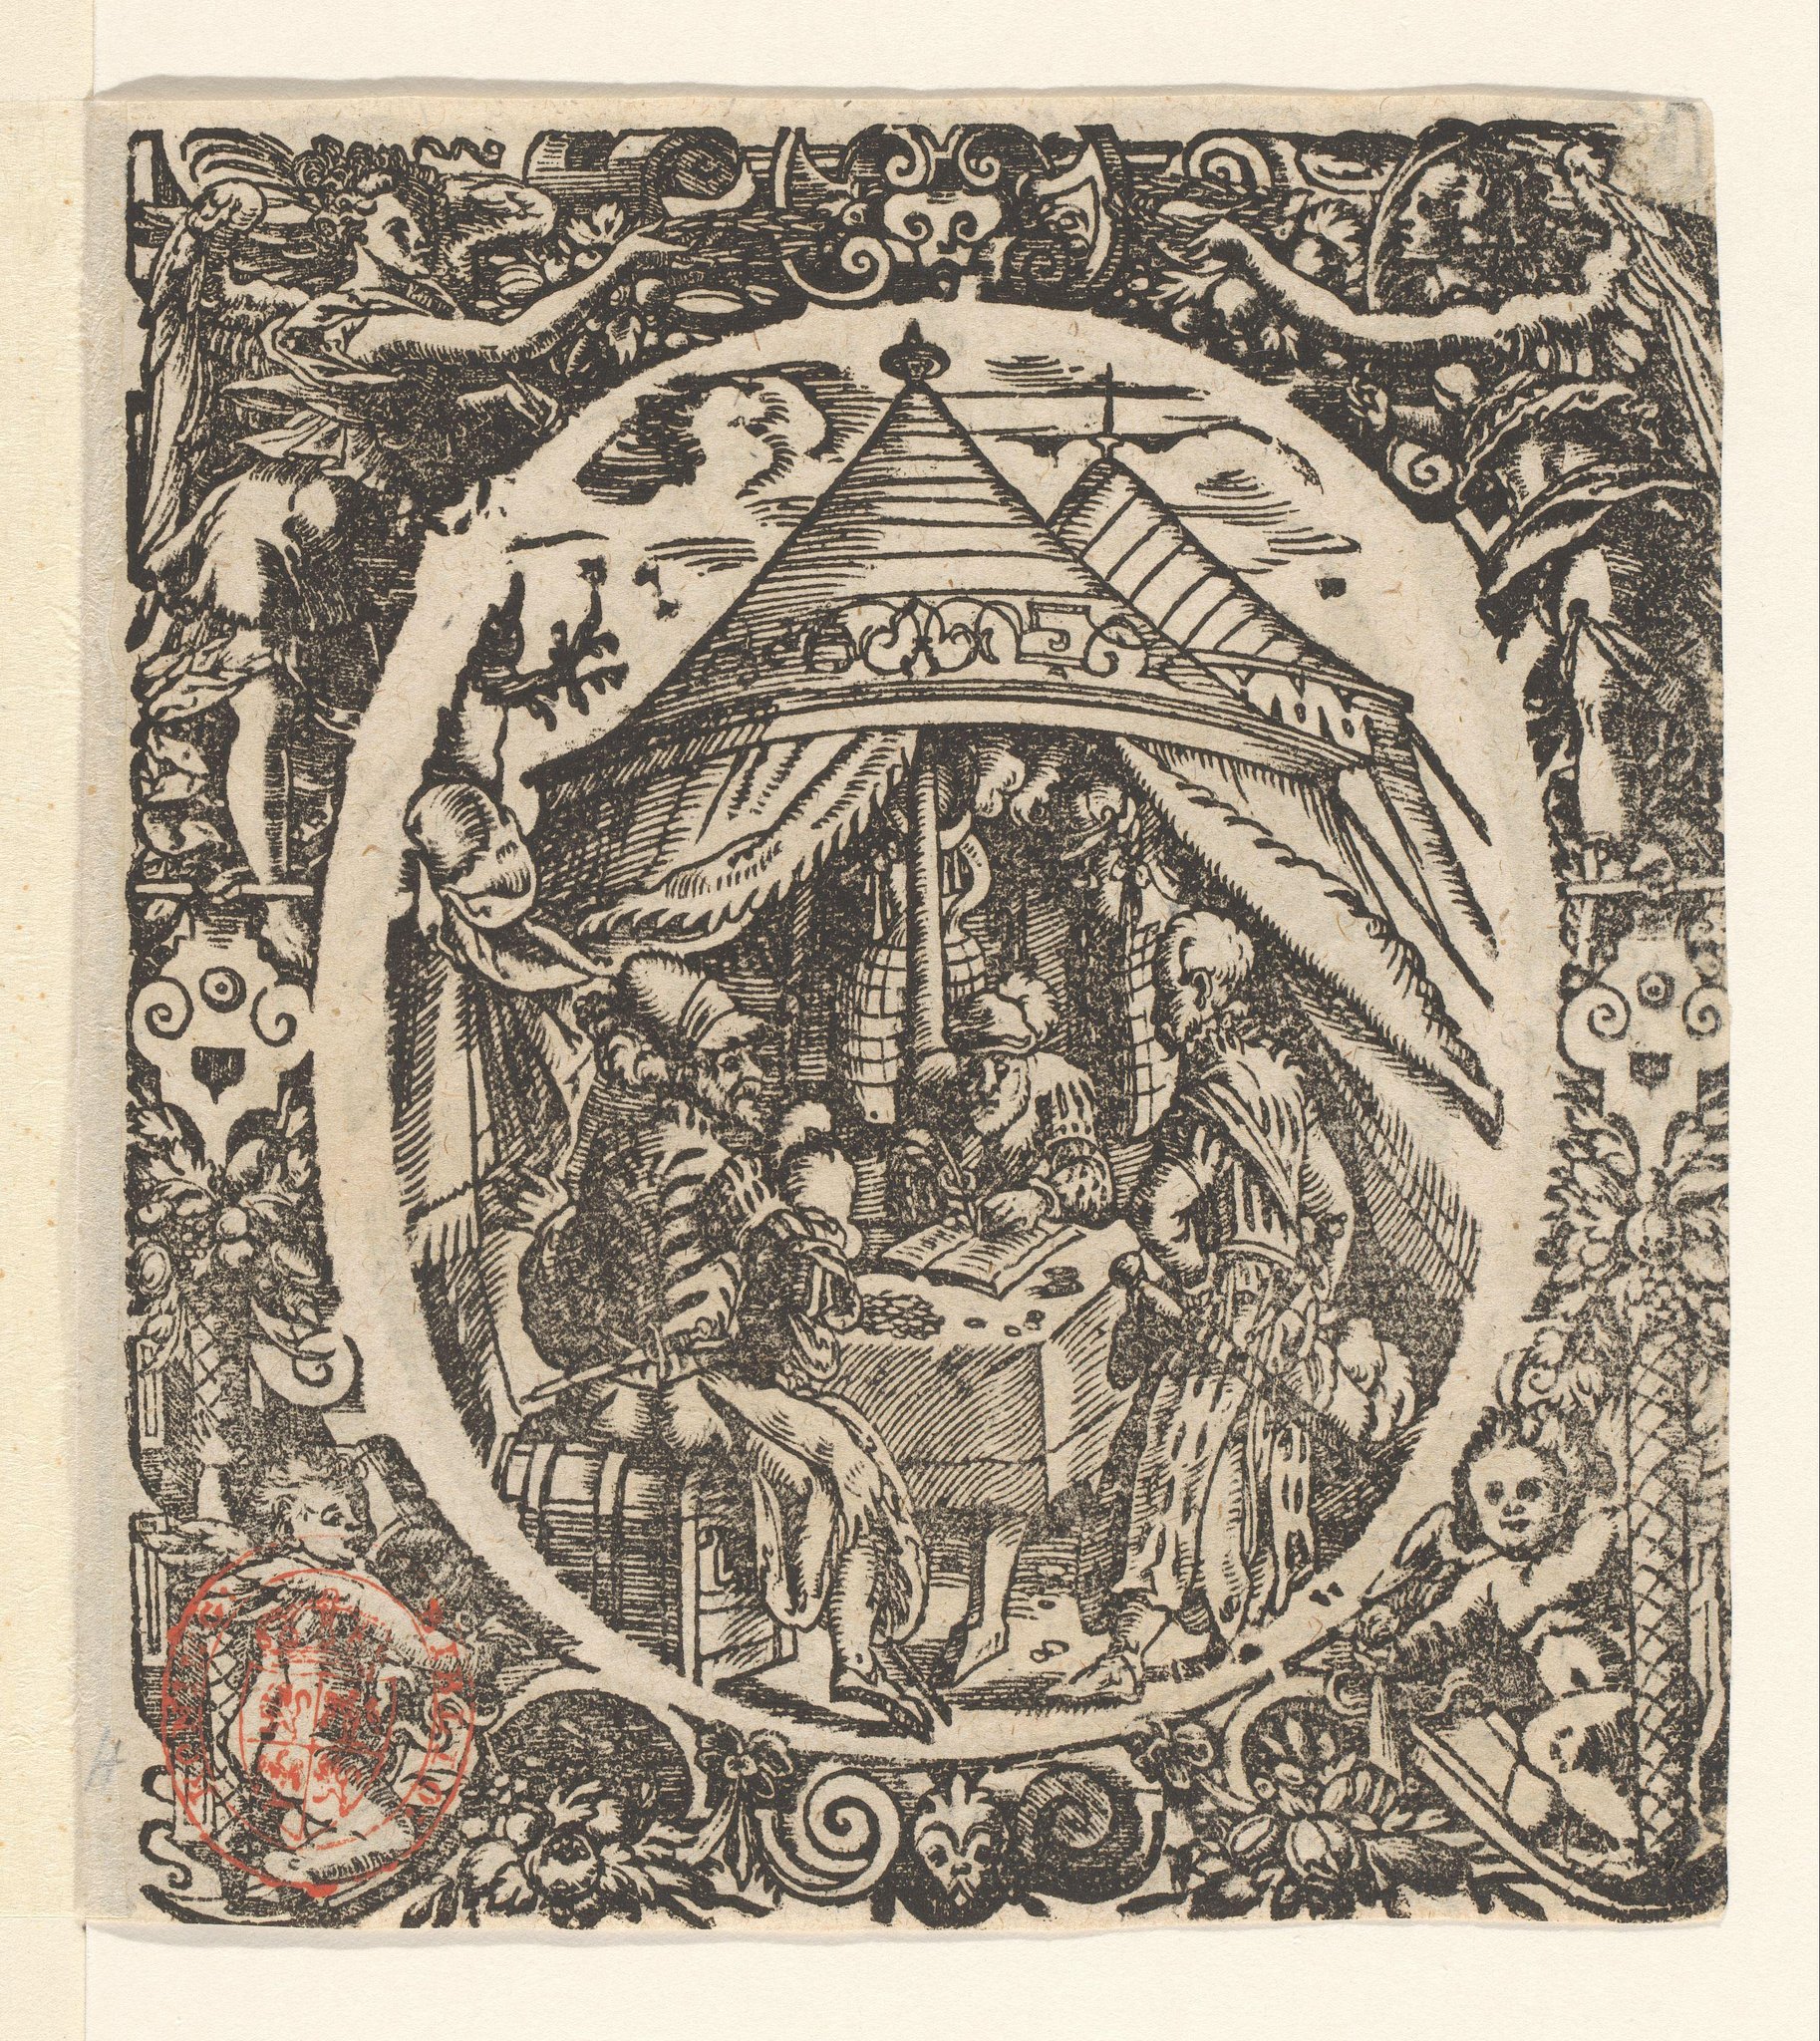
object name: print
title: Uitbetaling van soldij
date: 1573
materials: paper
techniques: woodcut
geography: frankfurt am main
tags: warfare; military affairs, the soldier; the soldier's life, payment ~ military service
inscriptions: collector's mark: Lugt 240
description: Zowel de voorstelling als de ornamentrand werd gebruikt voor verschillende edities van Leonhardt Fronspergers Kriegsbuch.